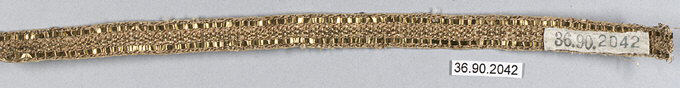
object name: galloon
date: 1601-1700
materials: metal thread, silk